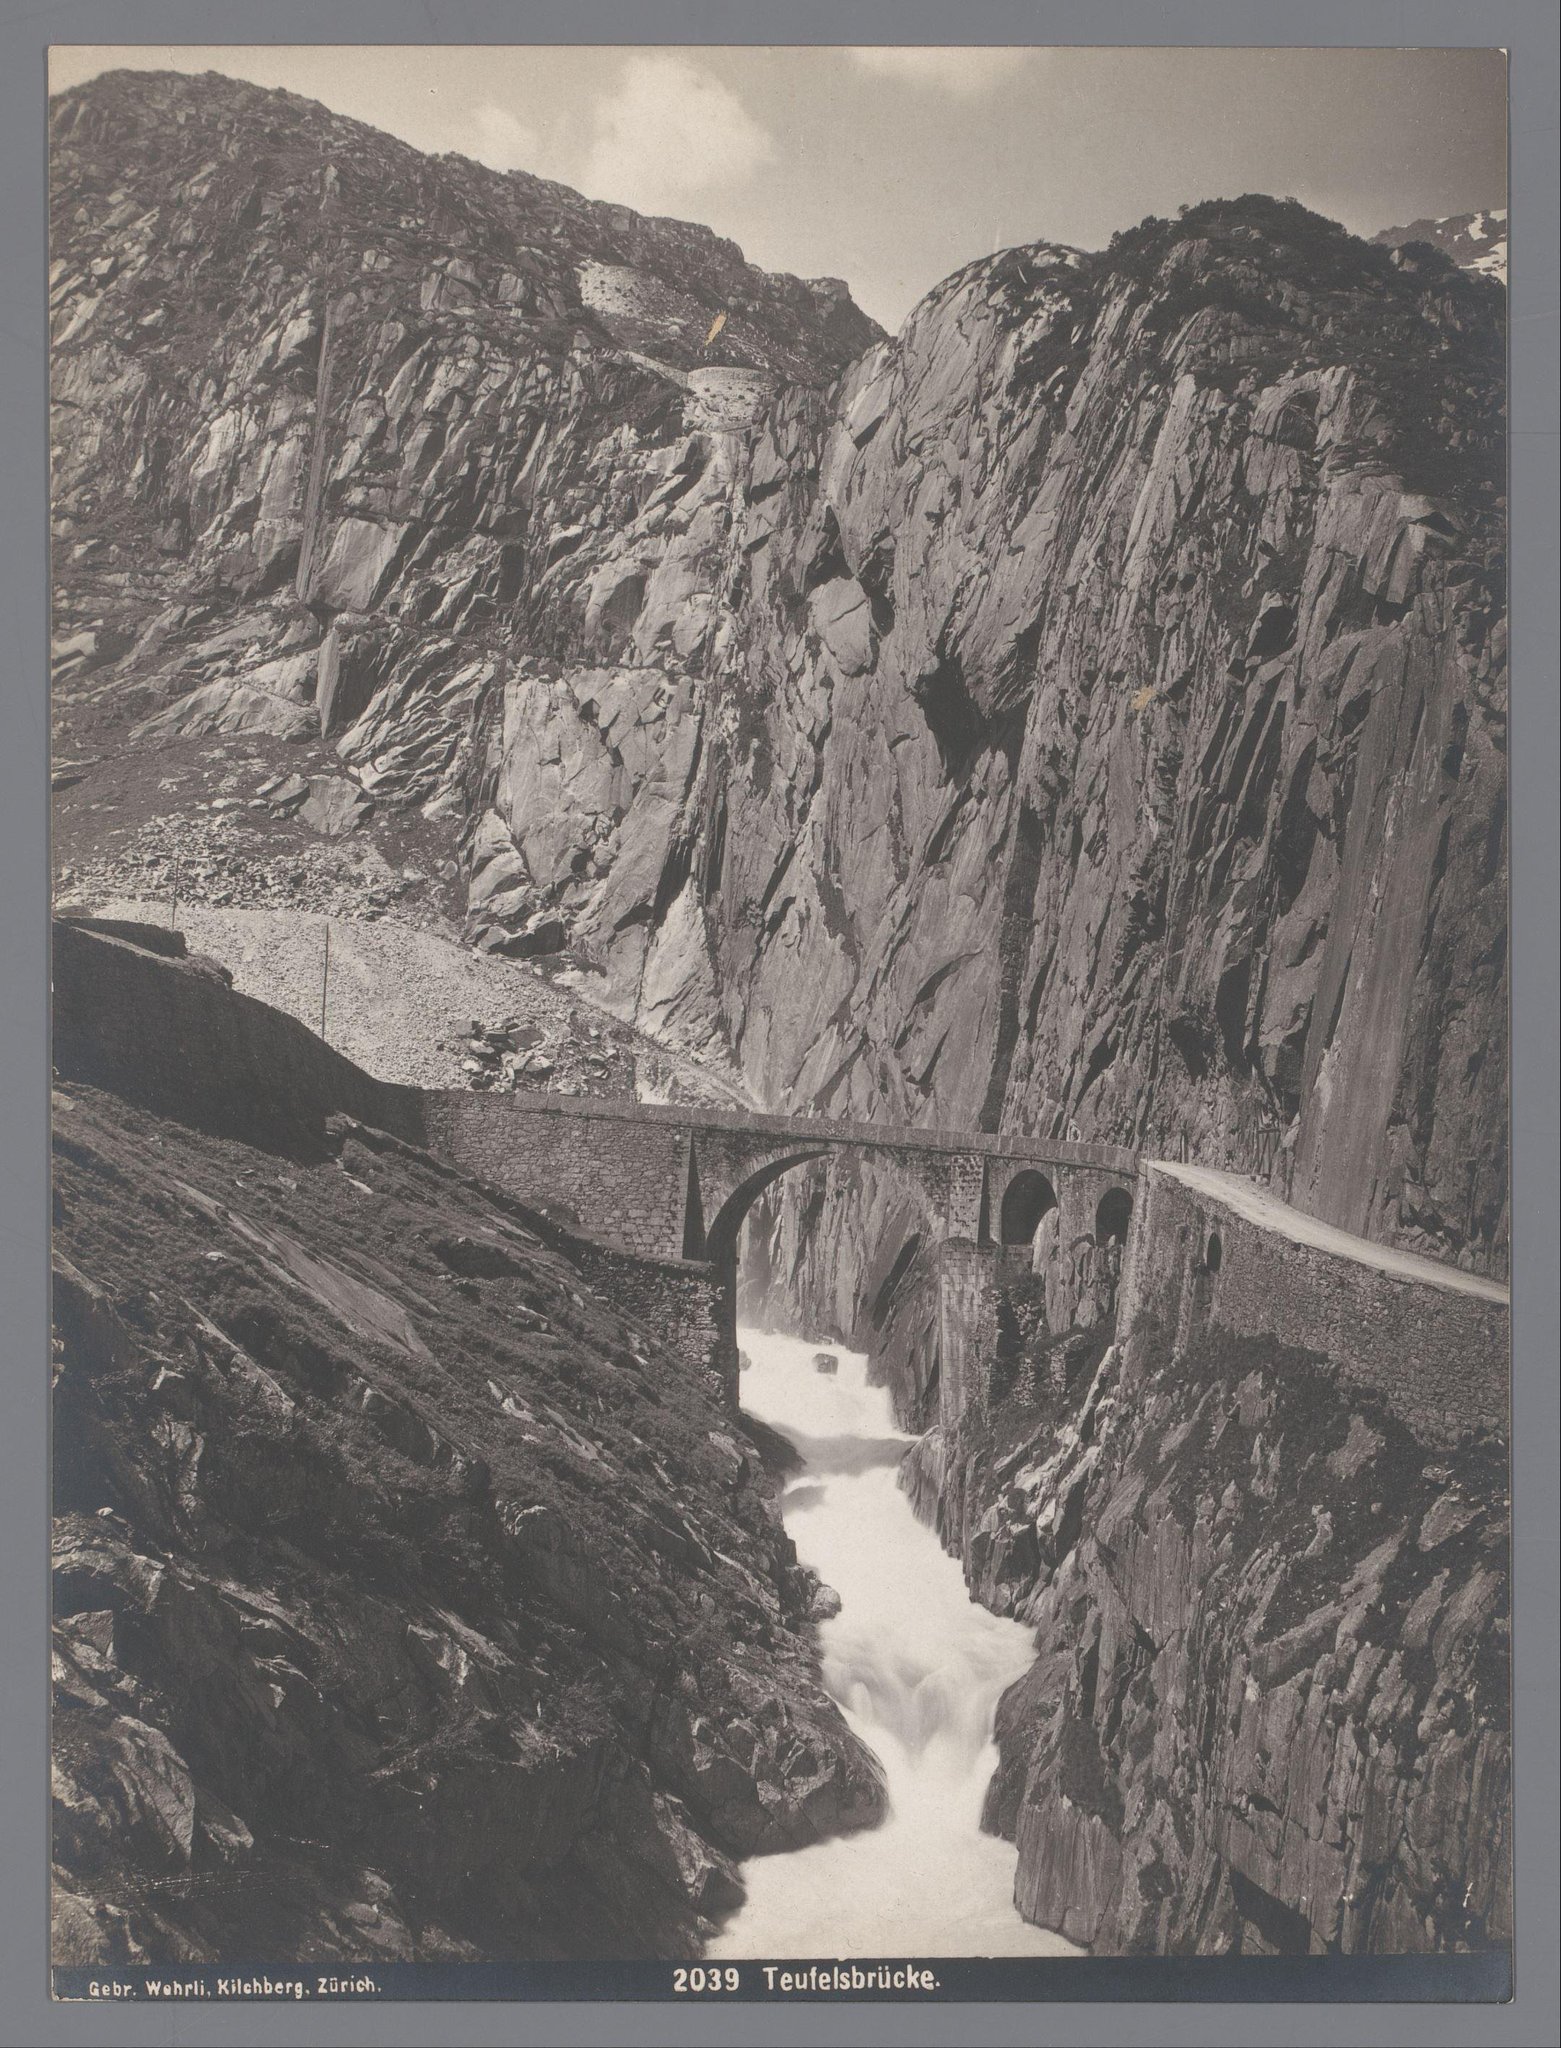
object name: photograph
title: Teufelsbrücke over de Schöllenenschlucht, bij de Gotthardpas, Zwitserland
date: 1900-1920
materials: cardboard, paper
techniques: gelatin silver print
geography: switzerland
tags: switzerland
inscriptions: inscription: ‘2039 Teufelsbrücke’, inscription: ‘Gebr. Wehrli, Kilchberg, Zürich.’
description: Brug over de Schöllenenschlucht, bij de Gotthardpass tussen Göschenen in het Noorden en Andermatt in het Zuiden (kanton Uri). Ertussen stroomt de rivier Reuss. De Gotthardpas verbindt kanton Uri met kanton Tessin. Vergelijk RP-F-00-6209 en RP-F-00-6222.